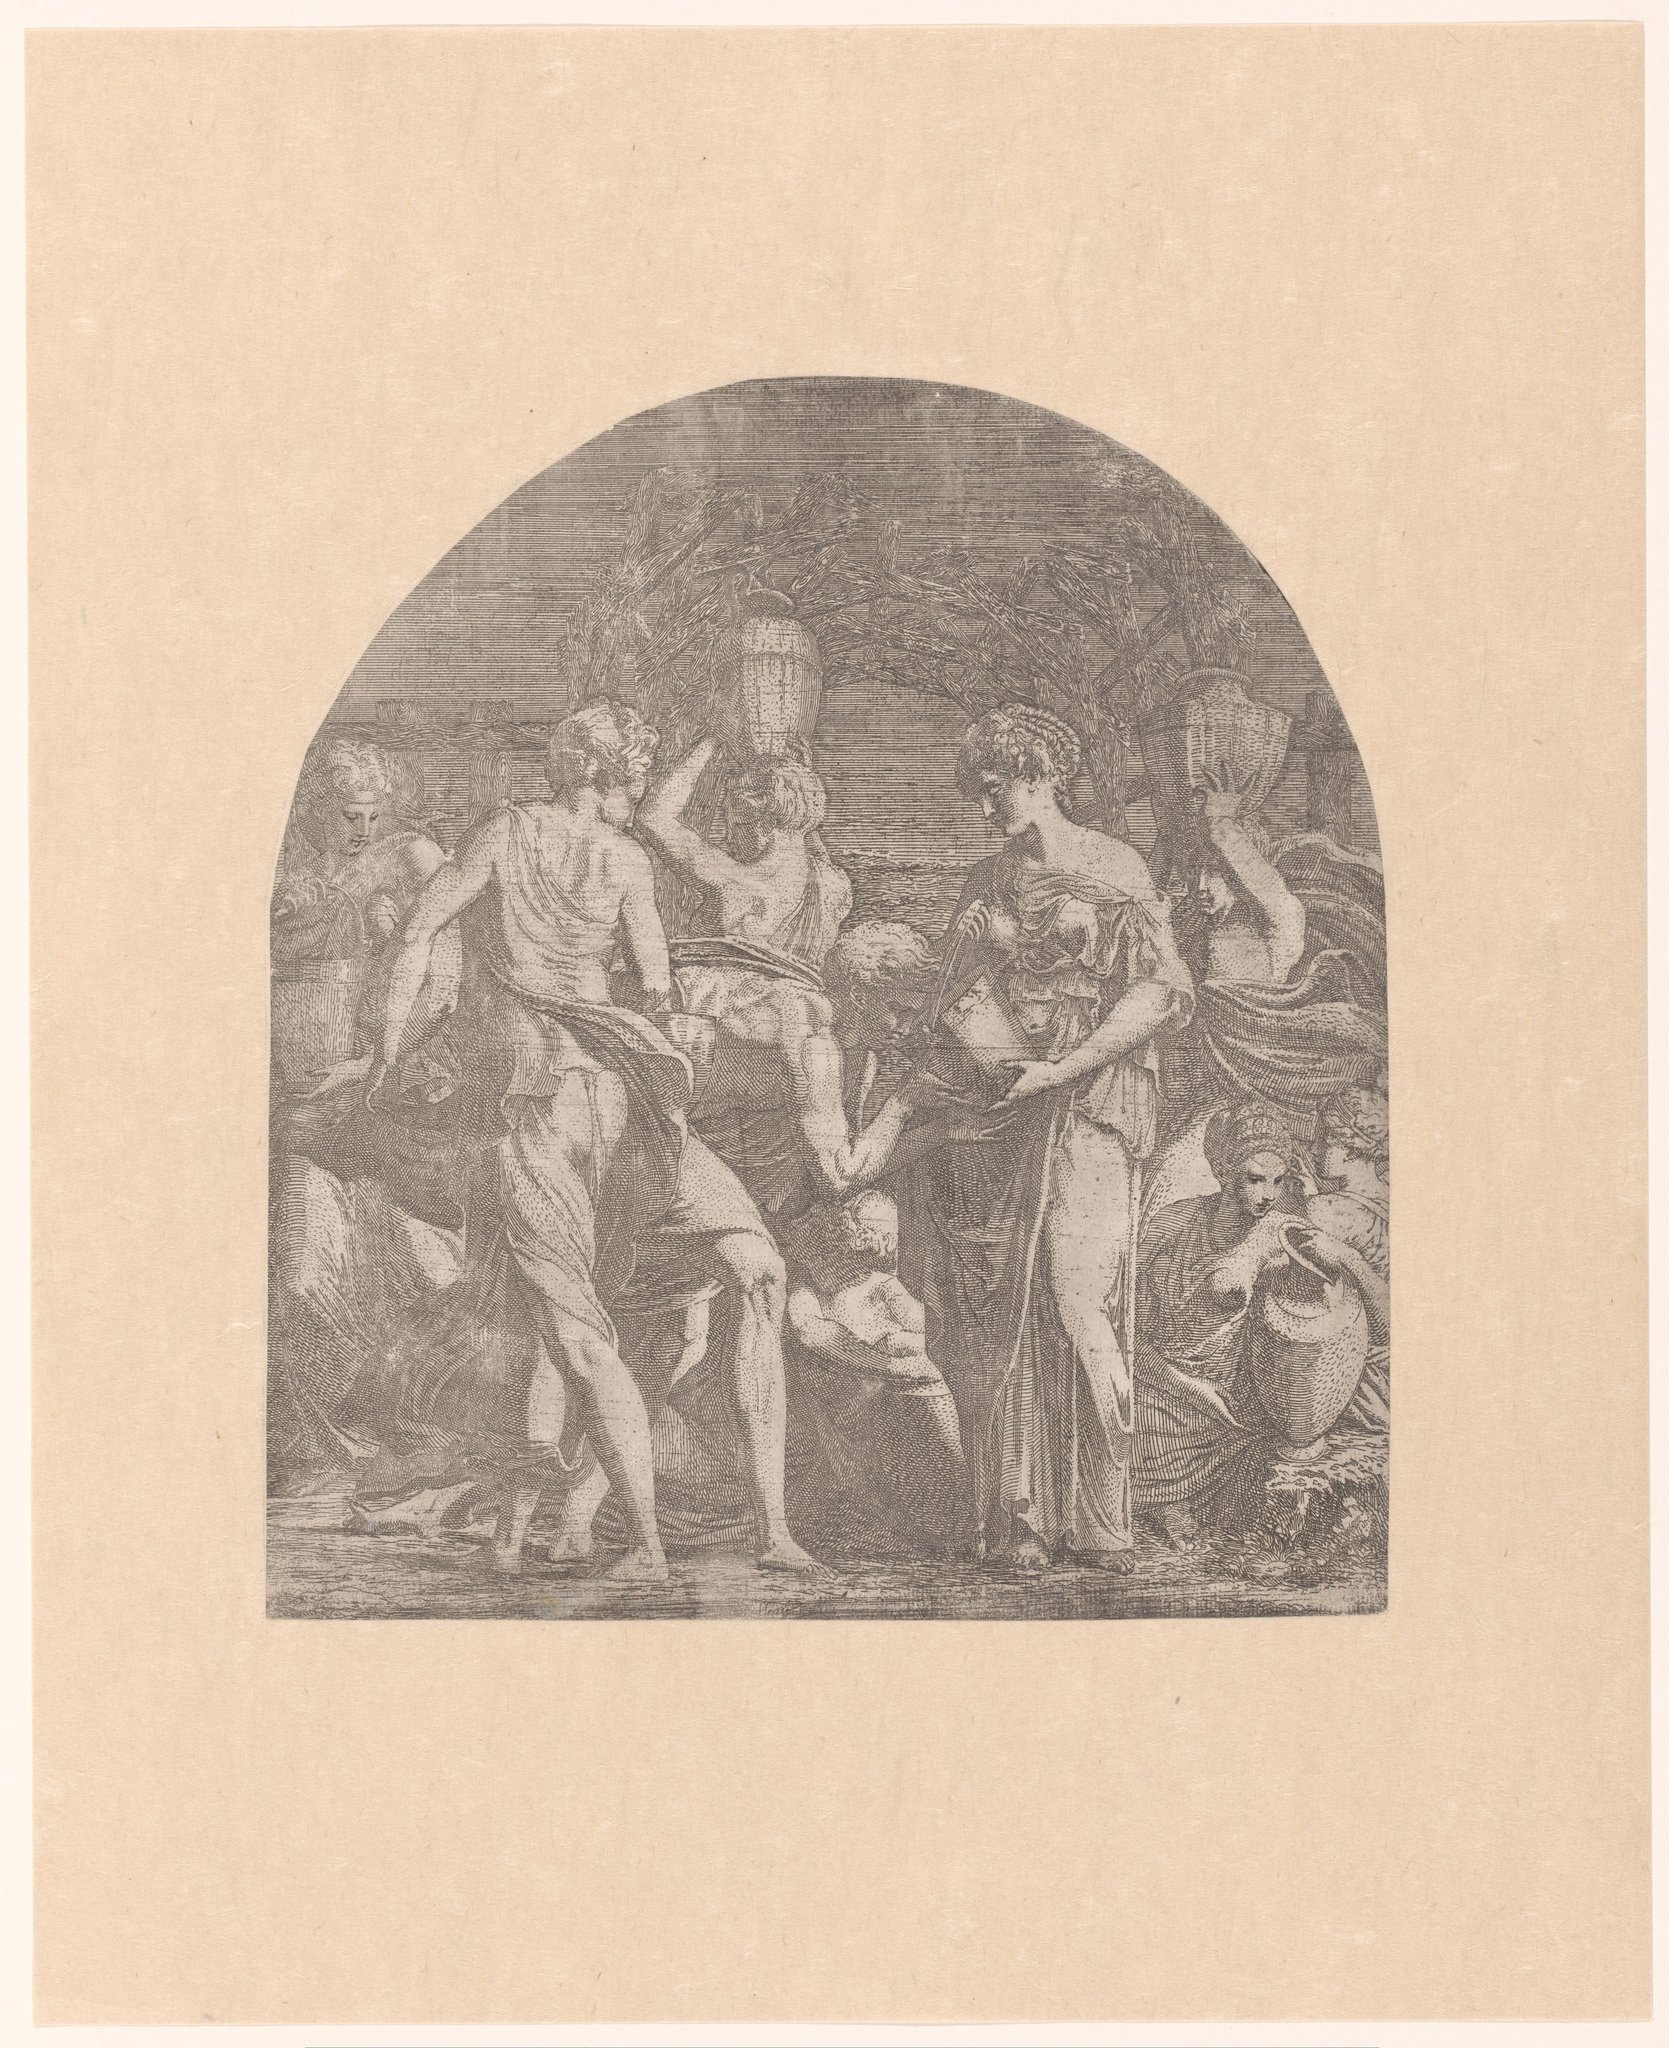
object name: print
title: Vrouw geeft een man te drinken uit een emmer, mogelijk Eliëzer en Rebekka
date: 1540-1556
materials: paper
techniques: etching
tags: container of ceramics: jar, jug, pot, vase, the meeting at the well: eliezer sees rebekah coming with a pitcher, drinking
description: Vrouw geeft een man te drinken uit een emmer. Om hen heen overige figuren met kruiken.